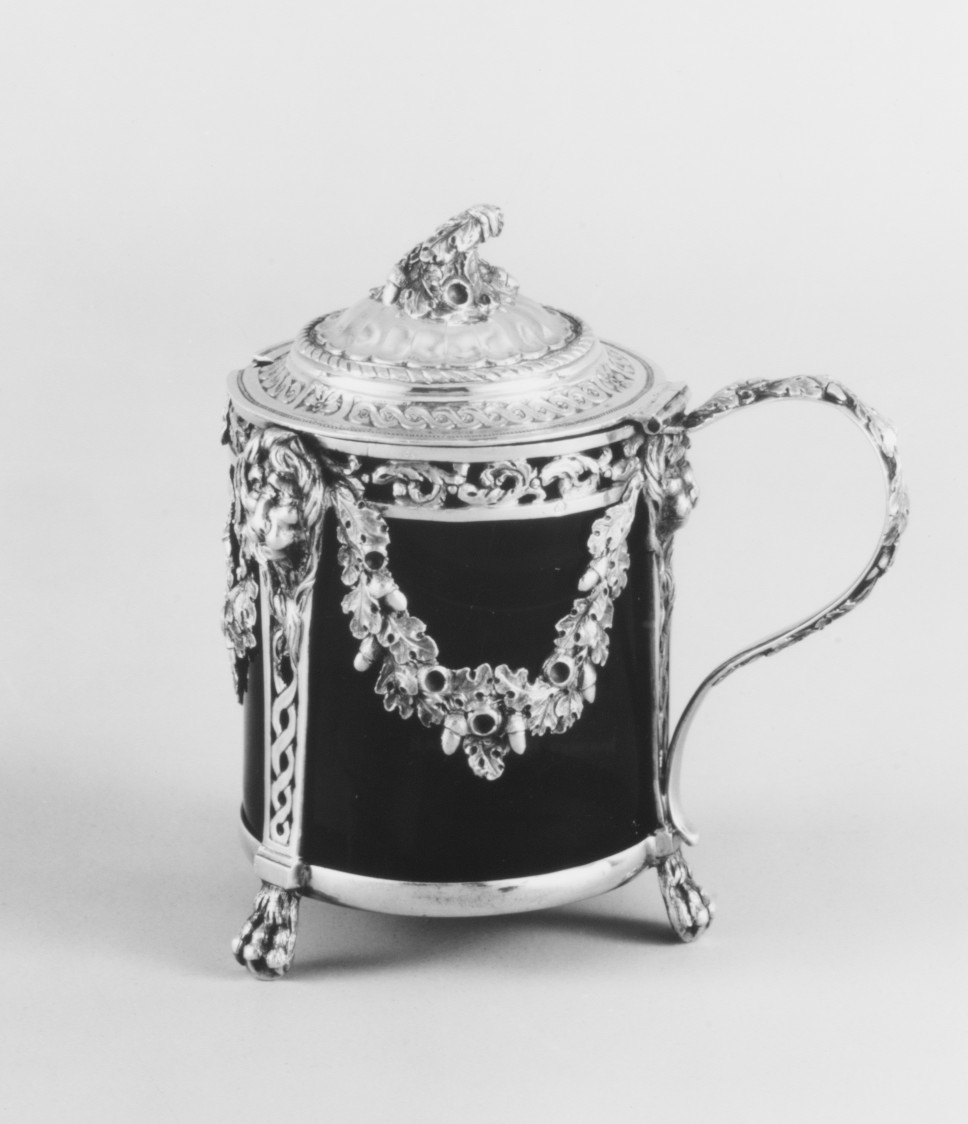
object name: mustard pot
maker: pierre-nicolas sommé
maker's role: maker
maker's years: 1730-1836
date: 1777-1778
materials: glass, silver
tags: garlands